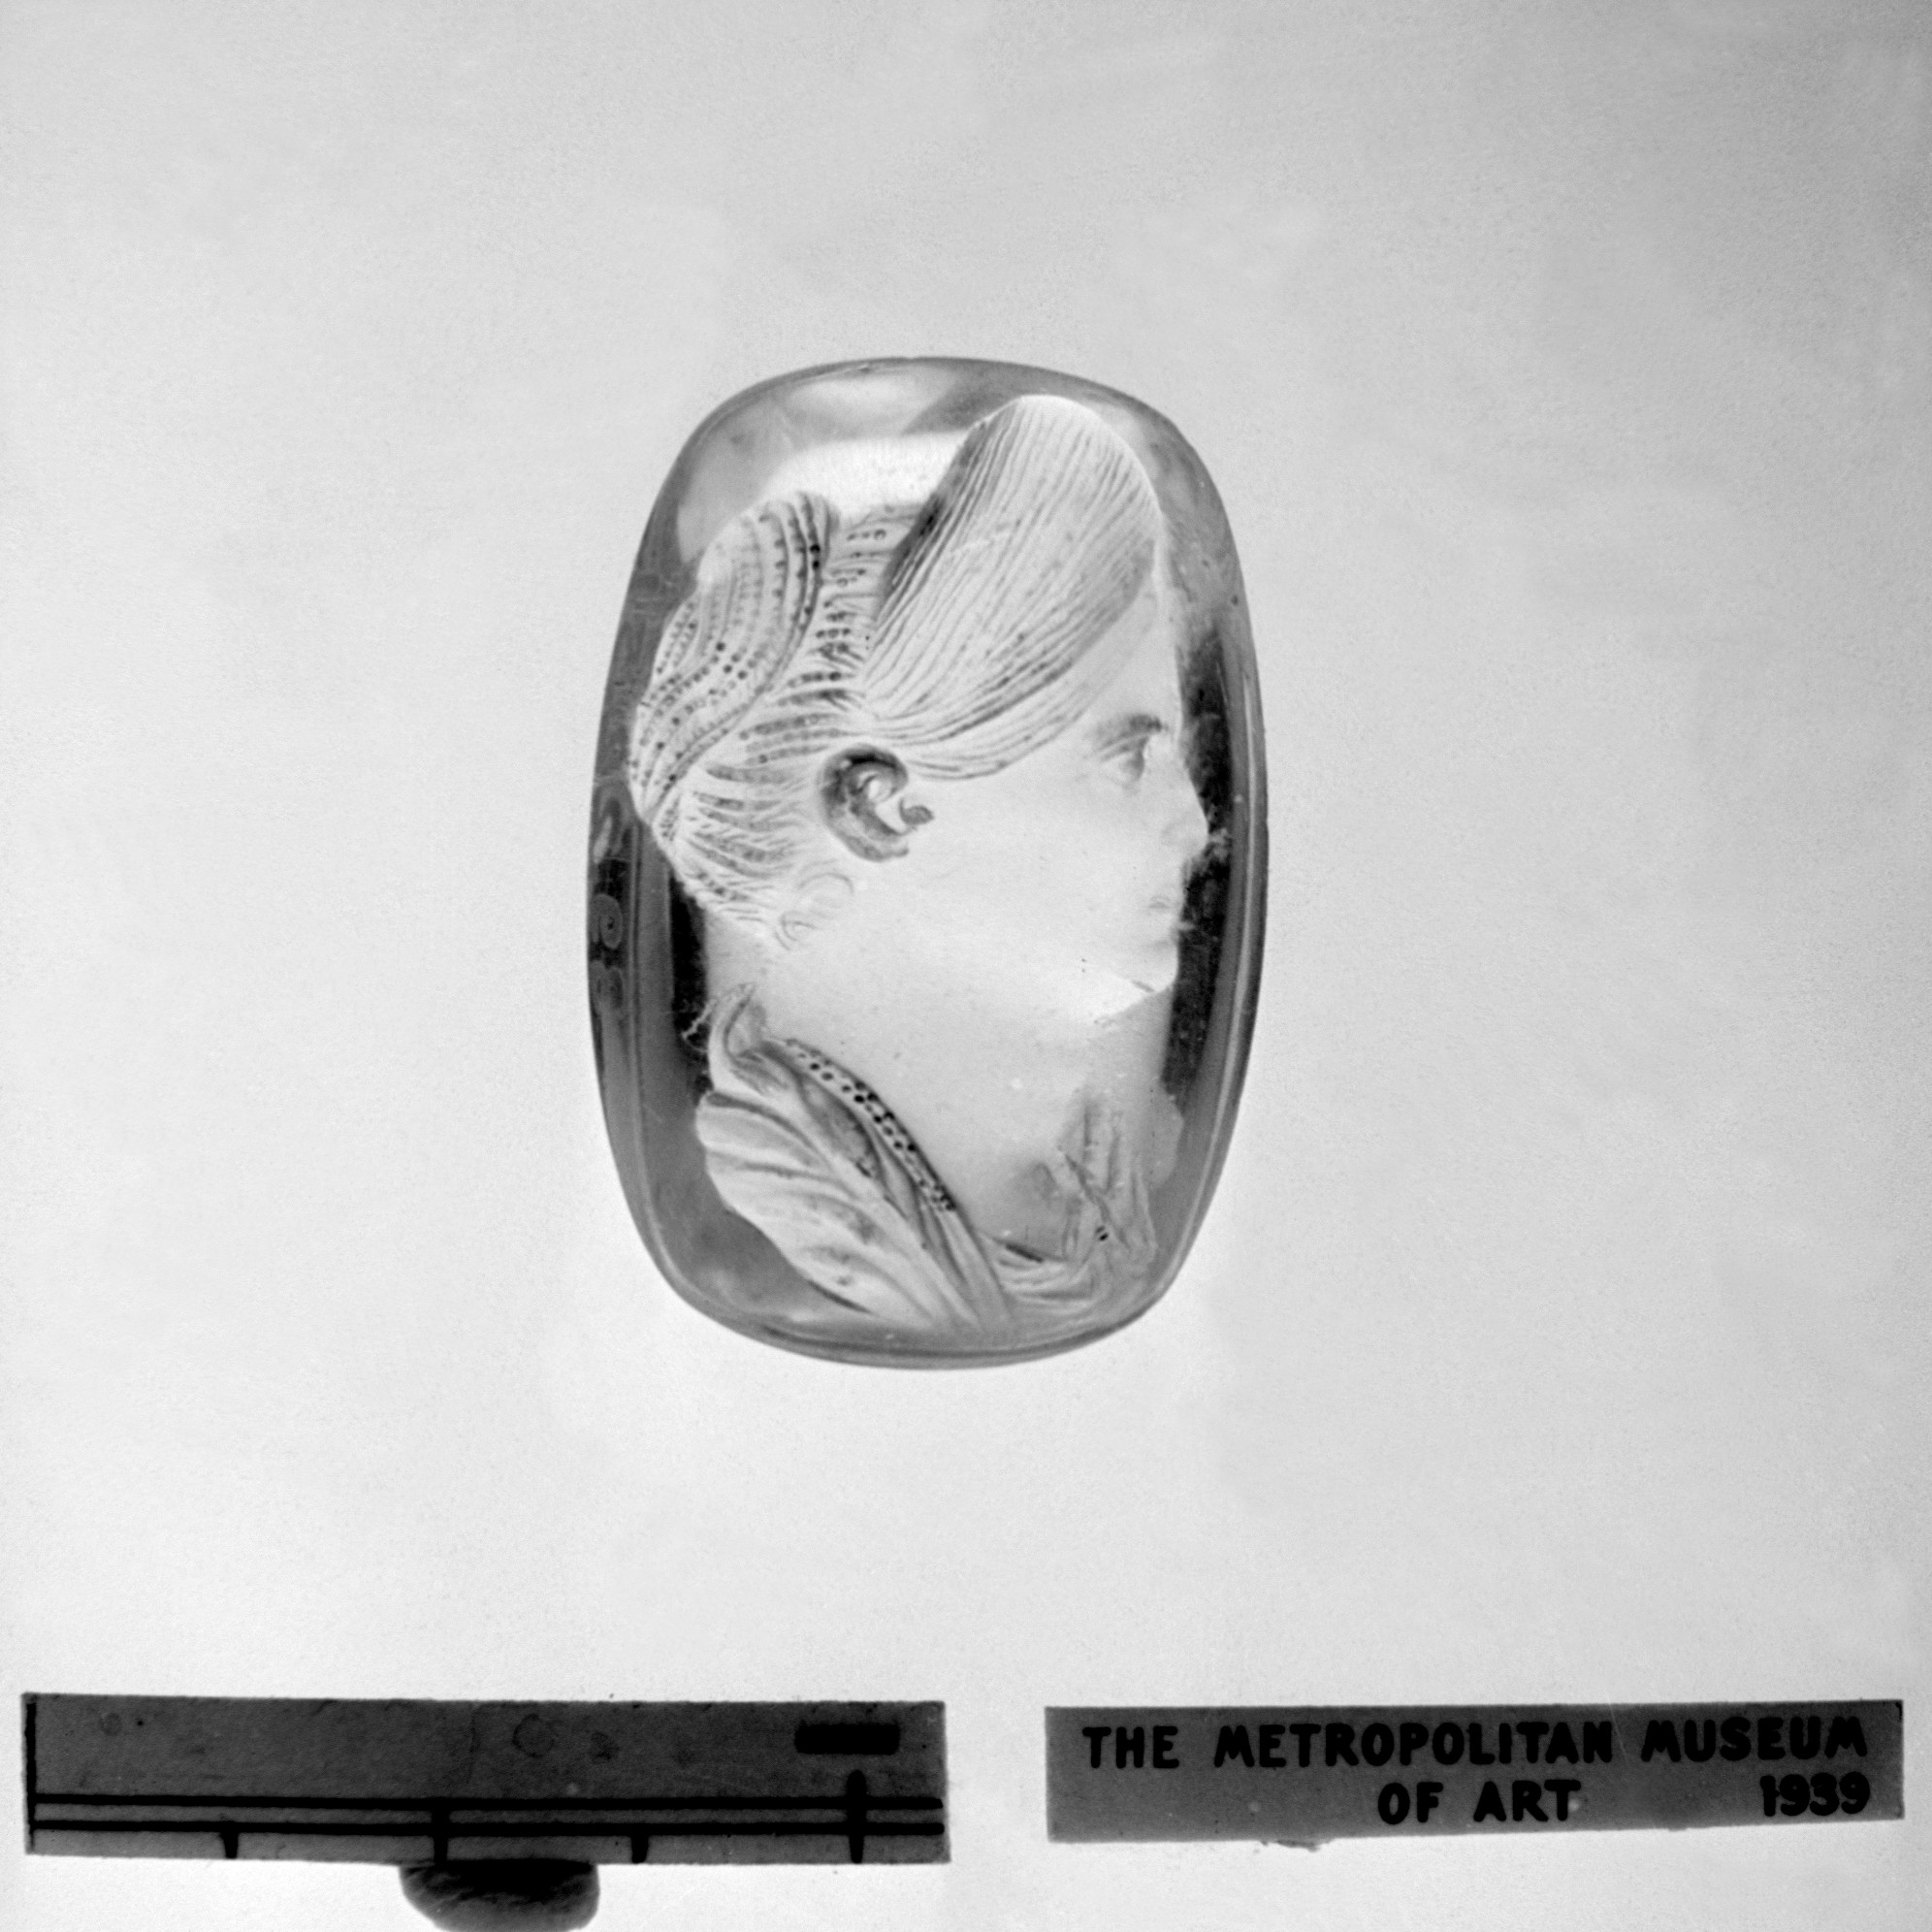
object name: intaglio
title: Head of a Roman lady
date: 1767-1800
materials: gemstone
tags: heads,profiles,women